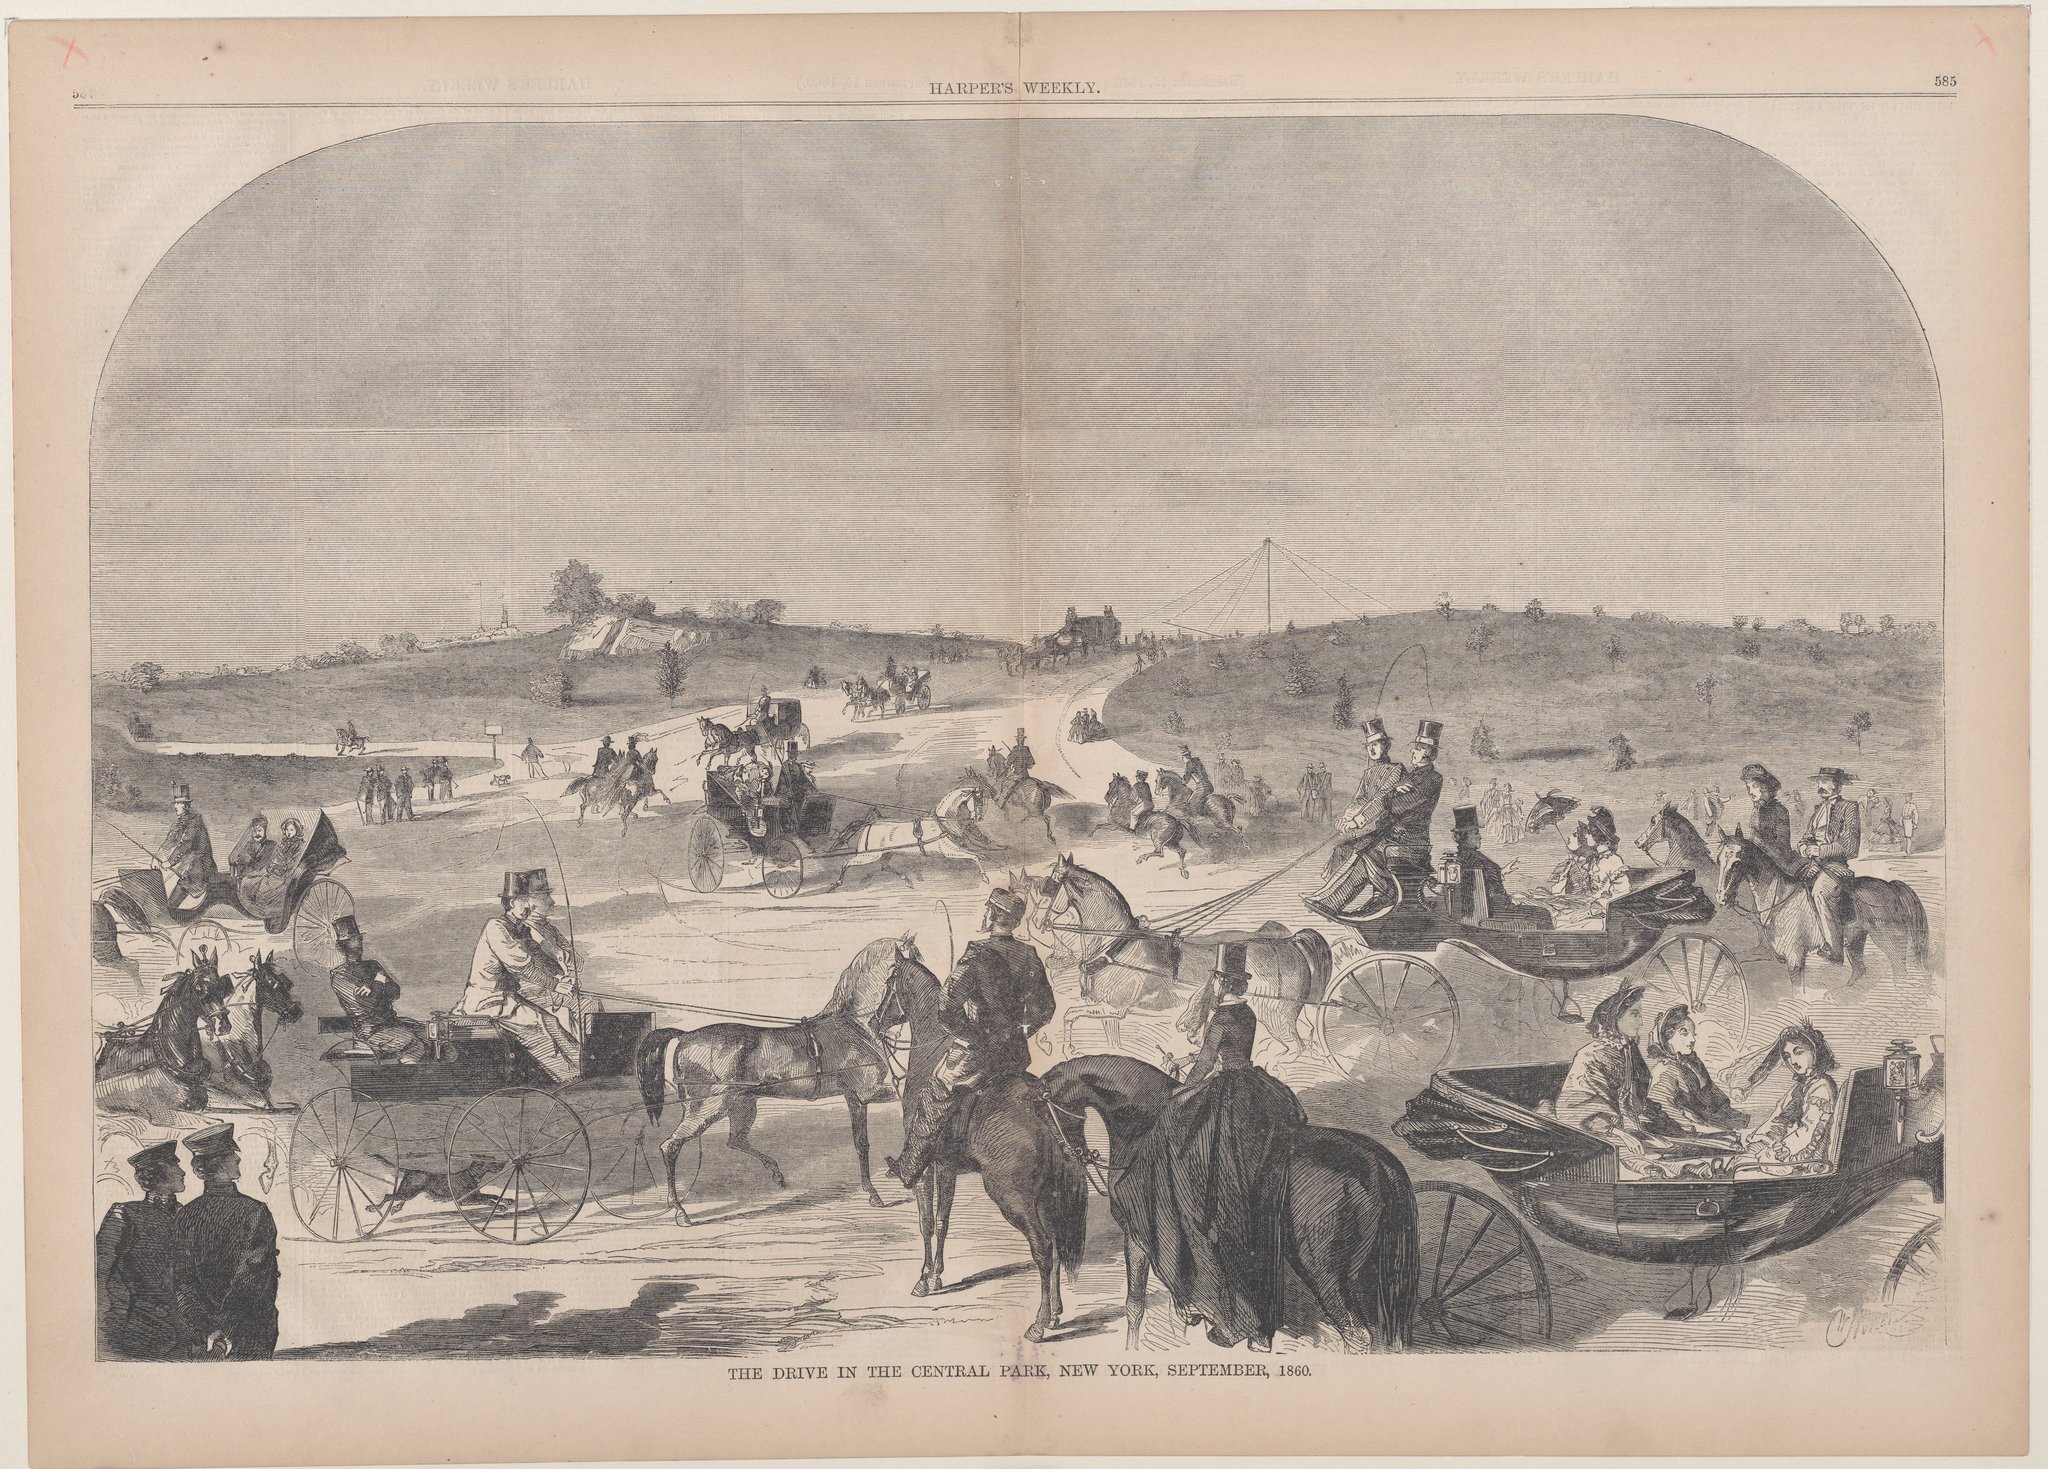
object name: print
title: The Drive in Central Park, New York (from "Harper's Weekly," Vol. IV)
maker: winslow homer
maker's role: artist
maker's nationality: american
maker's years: 1836-1910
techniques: engraving